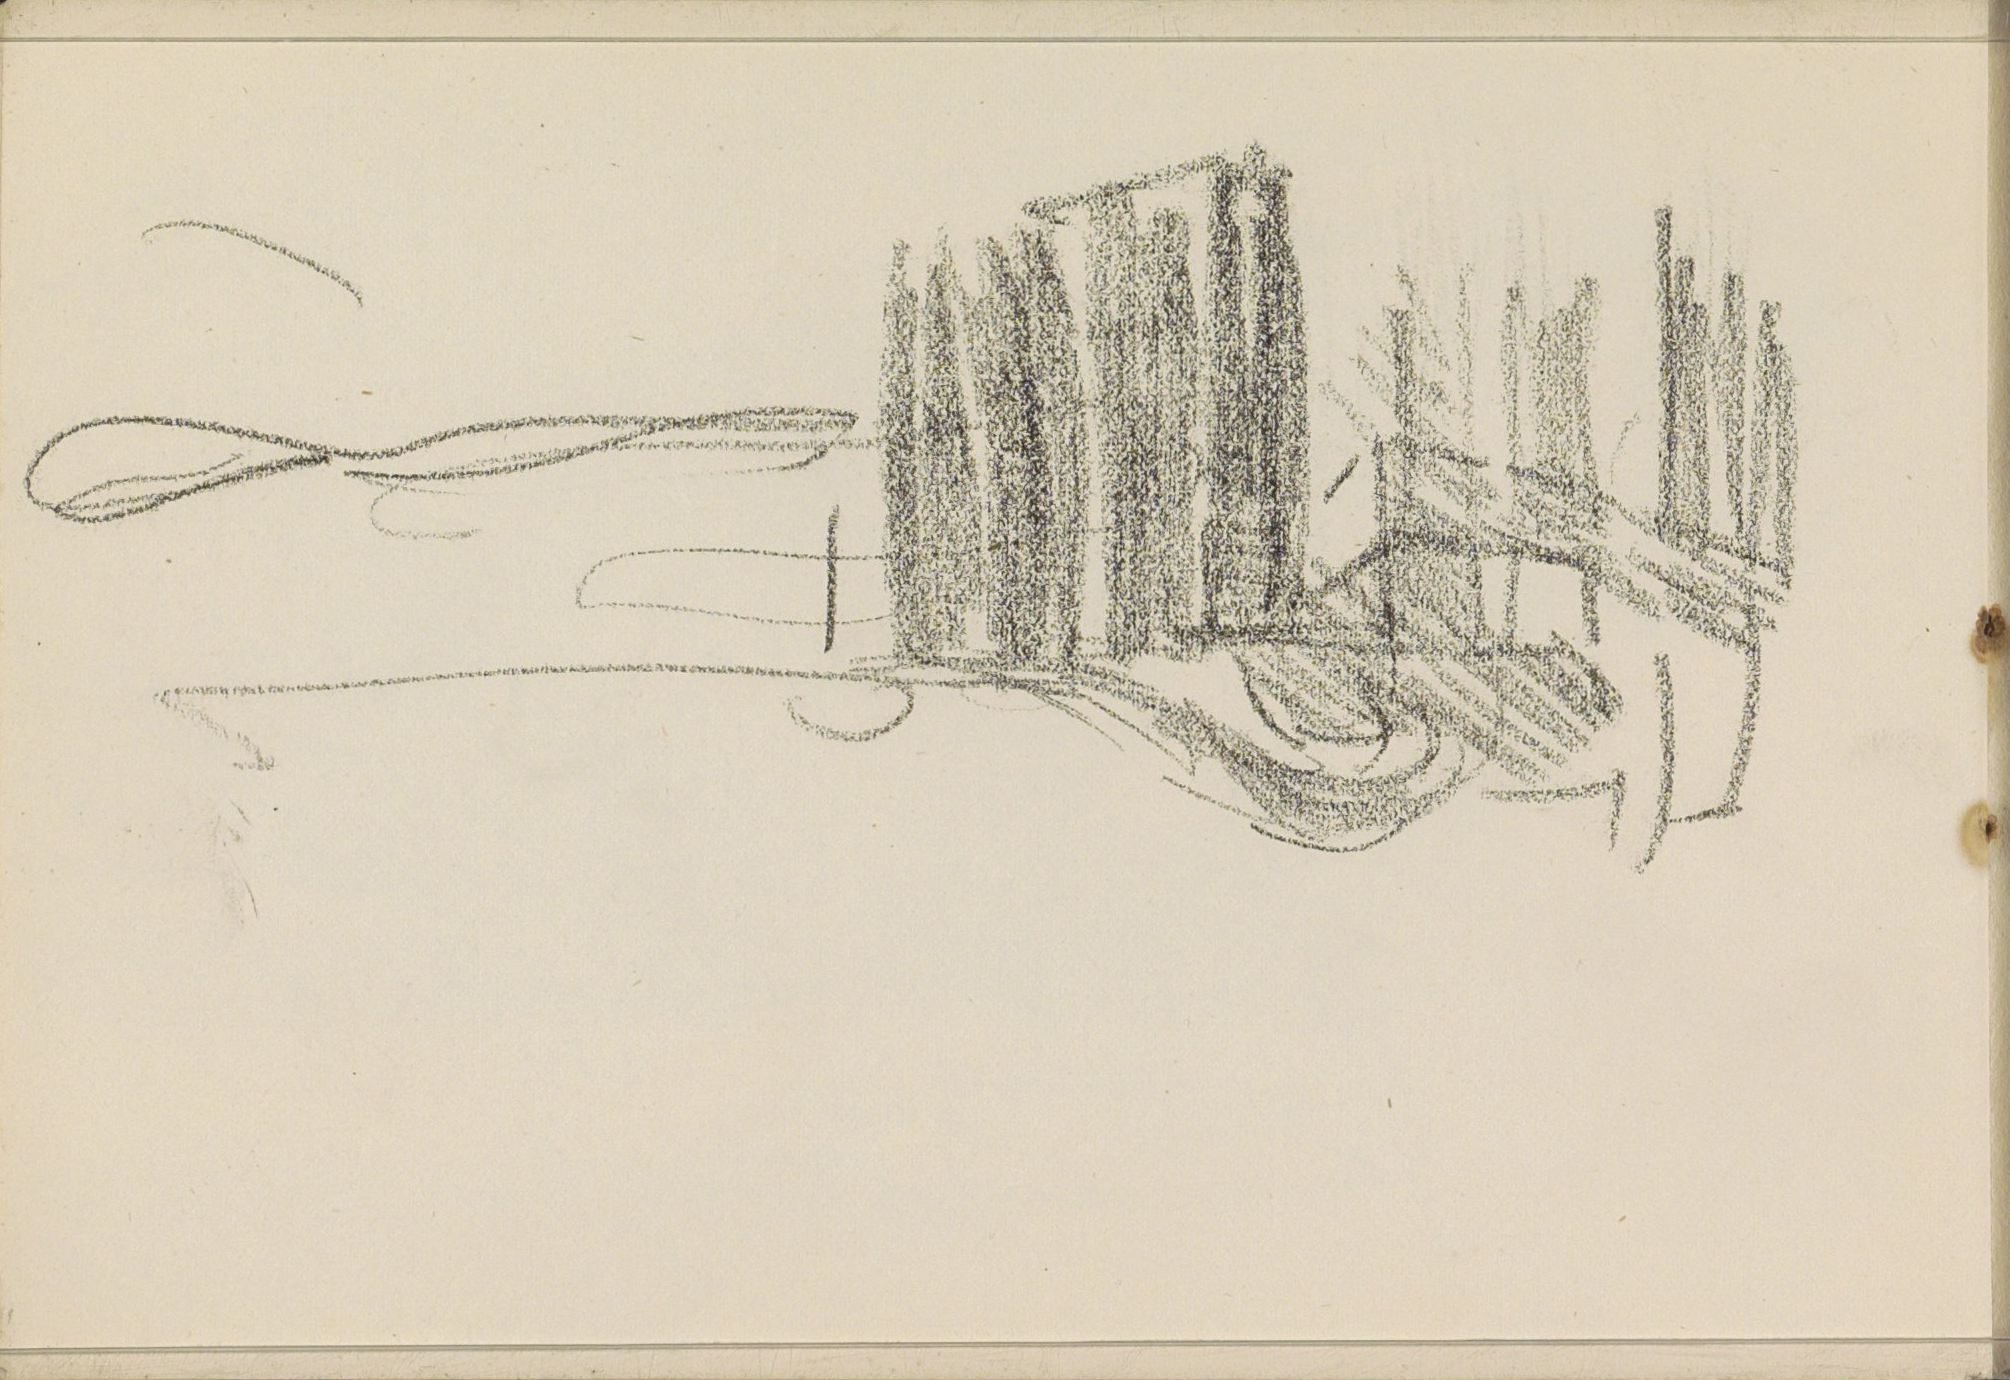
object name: sketchbook leaf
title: Studie, mogelijk van eent trap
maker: isaac israels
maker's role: draughtsman, painter, print maker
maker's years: 1865-1934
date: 1875-1934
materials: chalk, paper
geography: the hague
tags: staircase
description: Pagina 20 uit schetsboek XLII met 32 pagina's.